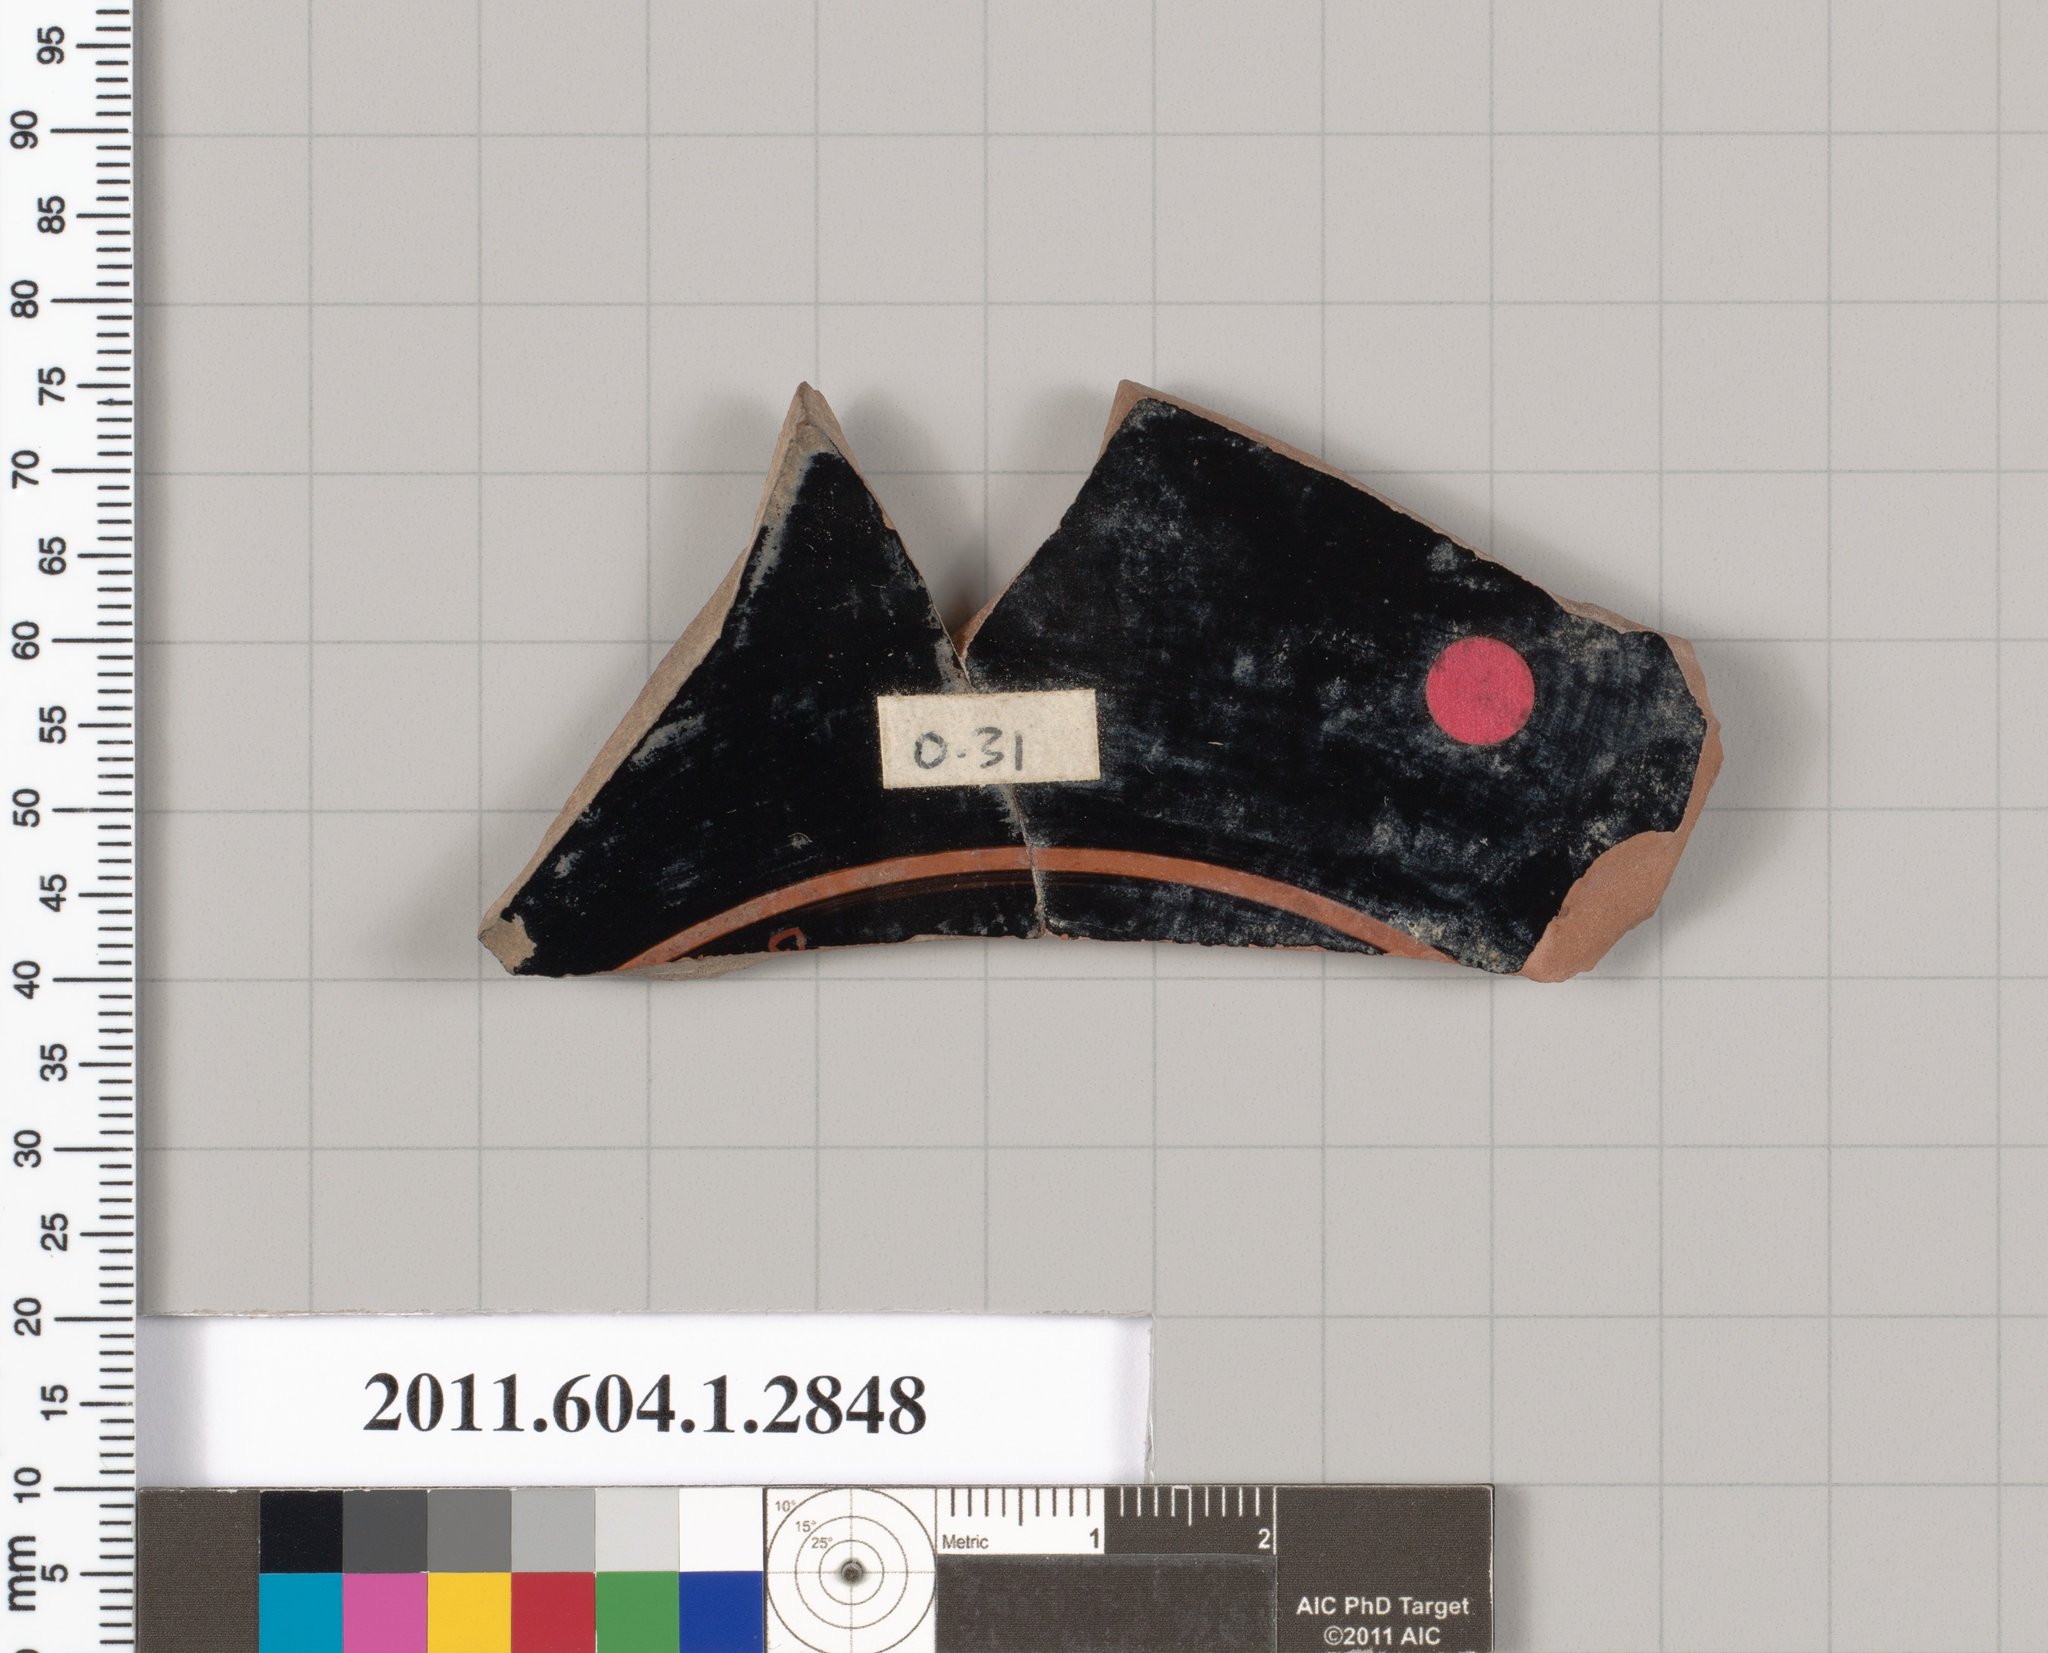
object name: kylix fragment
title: Terracotta fragment of a kylix (drinking cup)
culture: greek, attic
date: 520-480 BCE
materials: terracotta